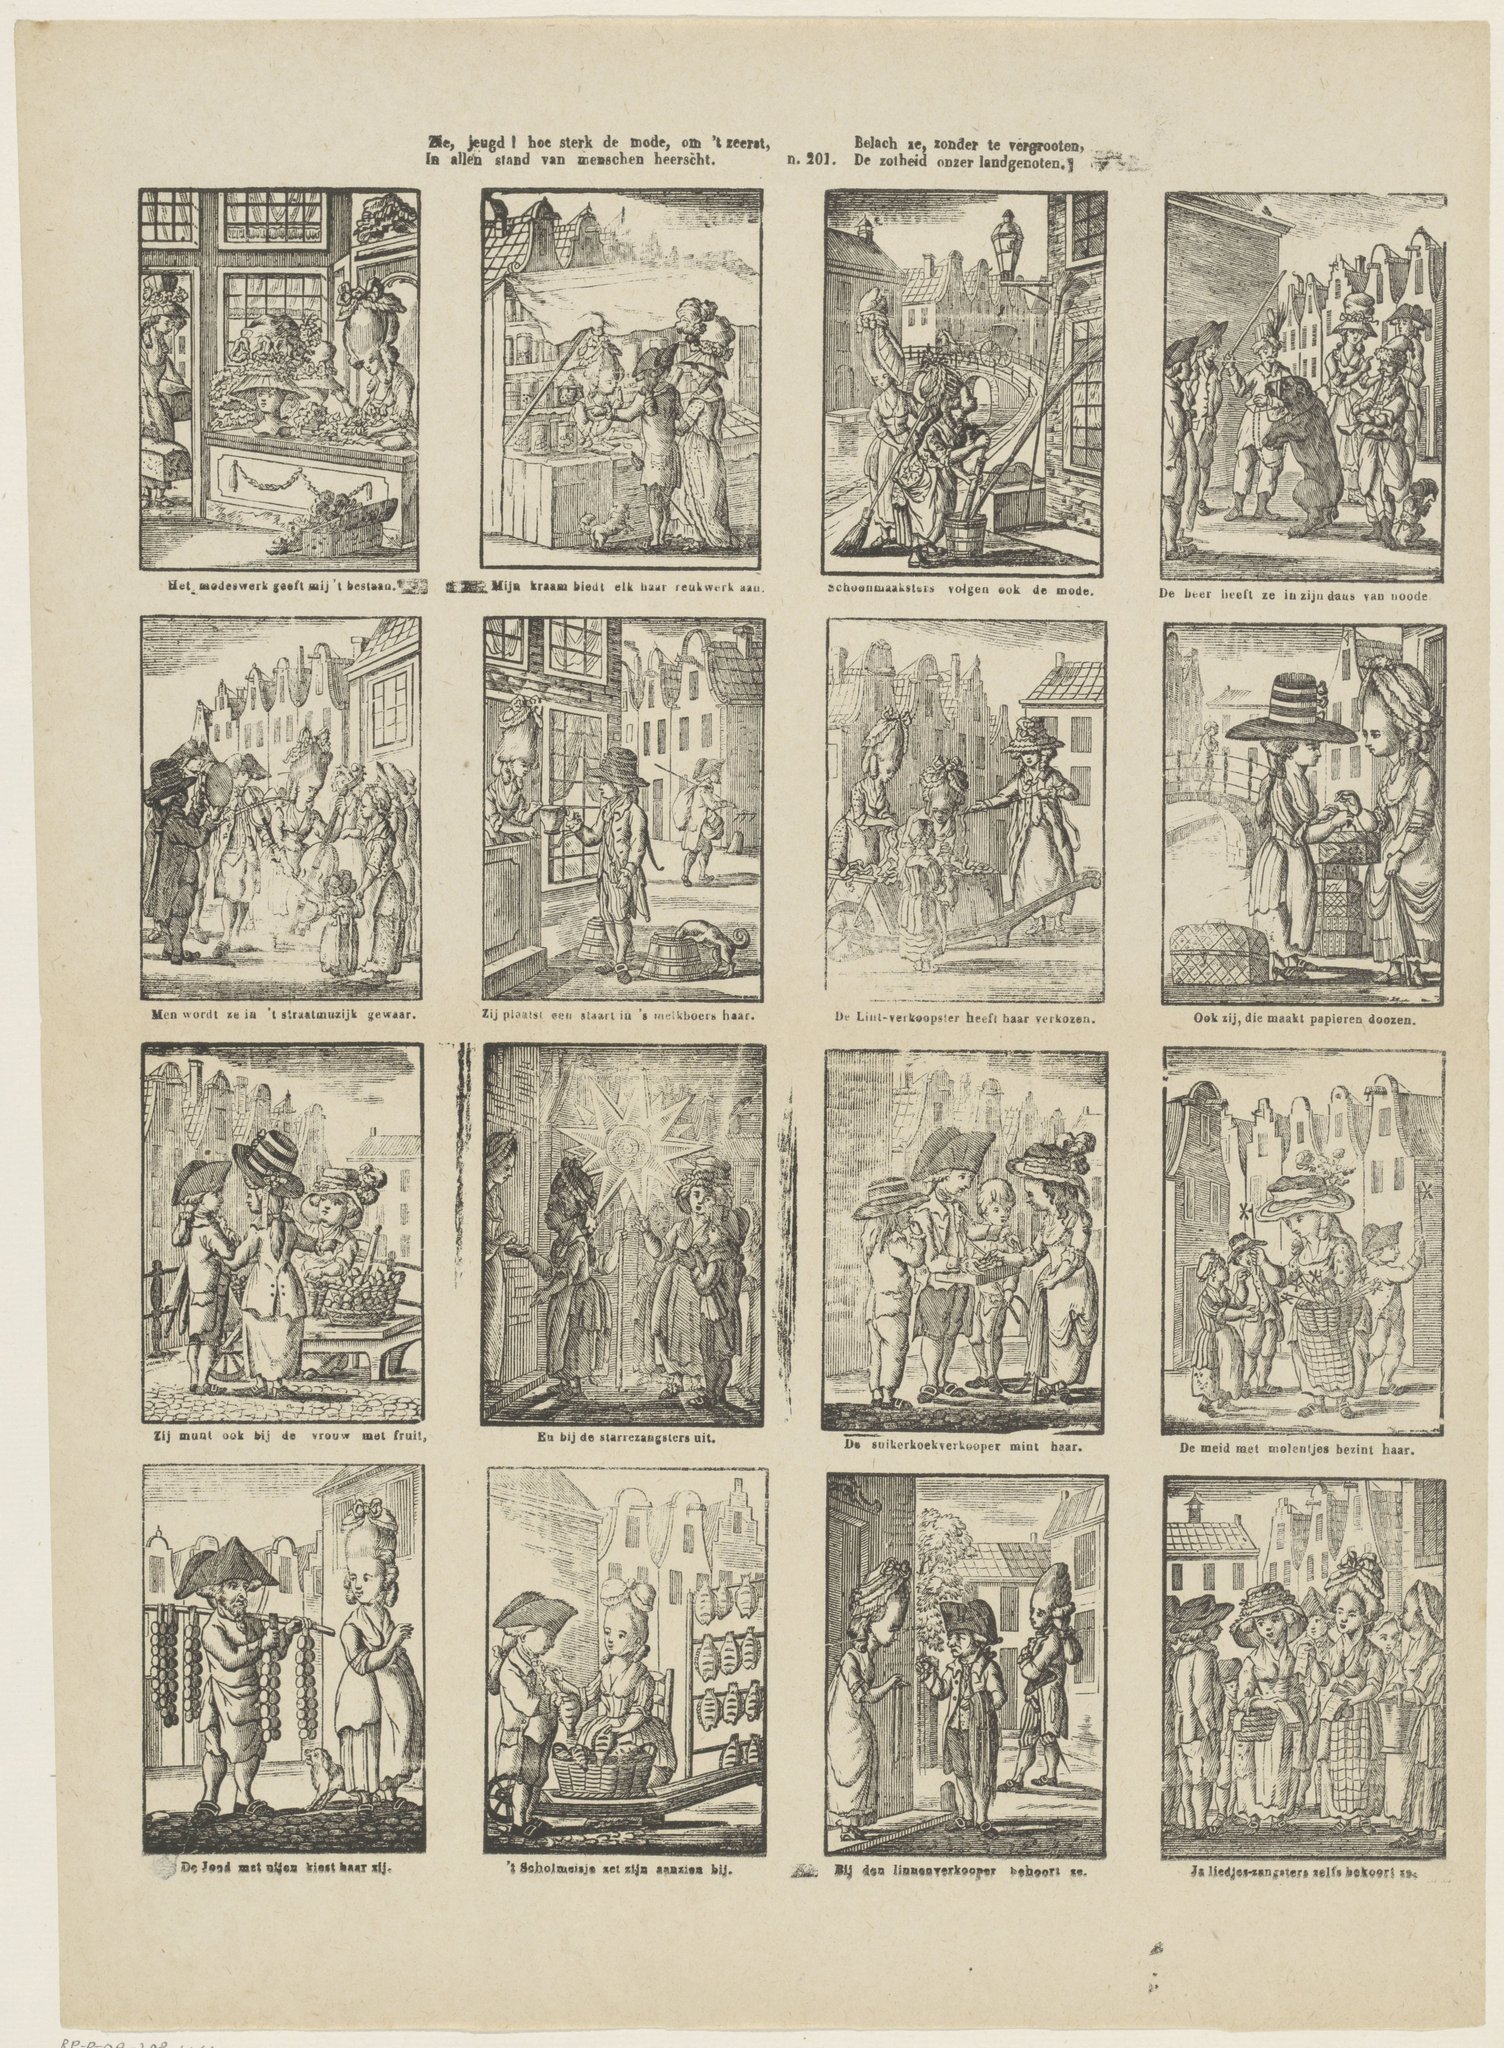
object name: cartoon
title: Zie, jeugd! hoe sterk de mode, om 't zeerst, / In allen stand van menschen heerscht. / Belach ze, zonder te vergrooten, / De zotheid onzer landgenoten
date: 1833-1900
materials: paper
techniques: letterpress printing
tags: fashion, clothing, caricatures (human types), fashion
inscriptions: collector's mark: Lugt 2760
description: Spotprent op de mode met 16 voorstellingen over mensen met opvallende hoeden. Onder elke afbeelding een onderschrift. Genummerd midden boven: n. 201.